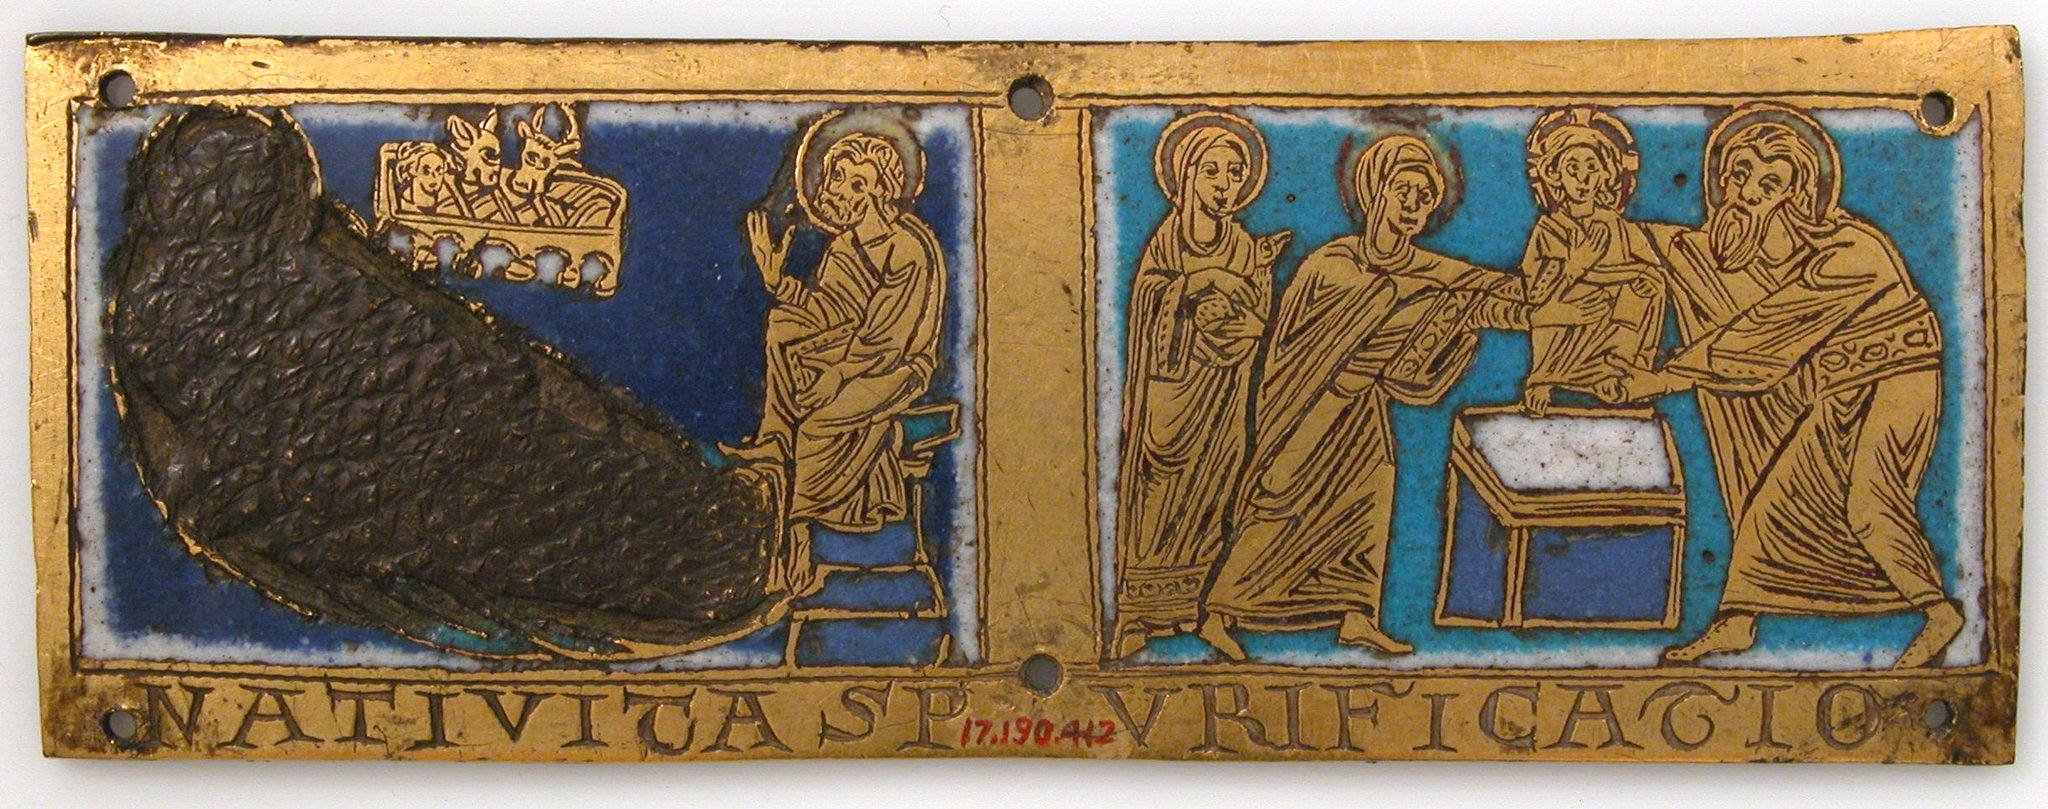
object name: plaque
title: Plaque from a Portable Altar with Scenes from the Life of Jesus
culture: german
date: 1160-1180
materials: gilt copper, enamel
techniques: enamel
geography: germany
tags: holy family,jesus,nativity